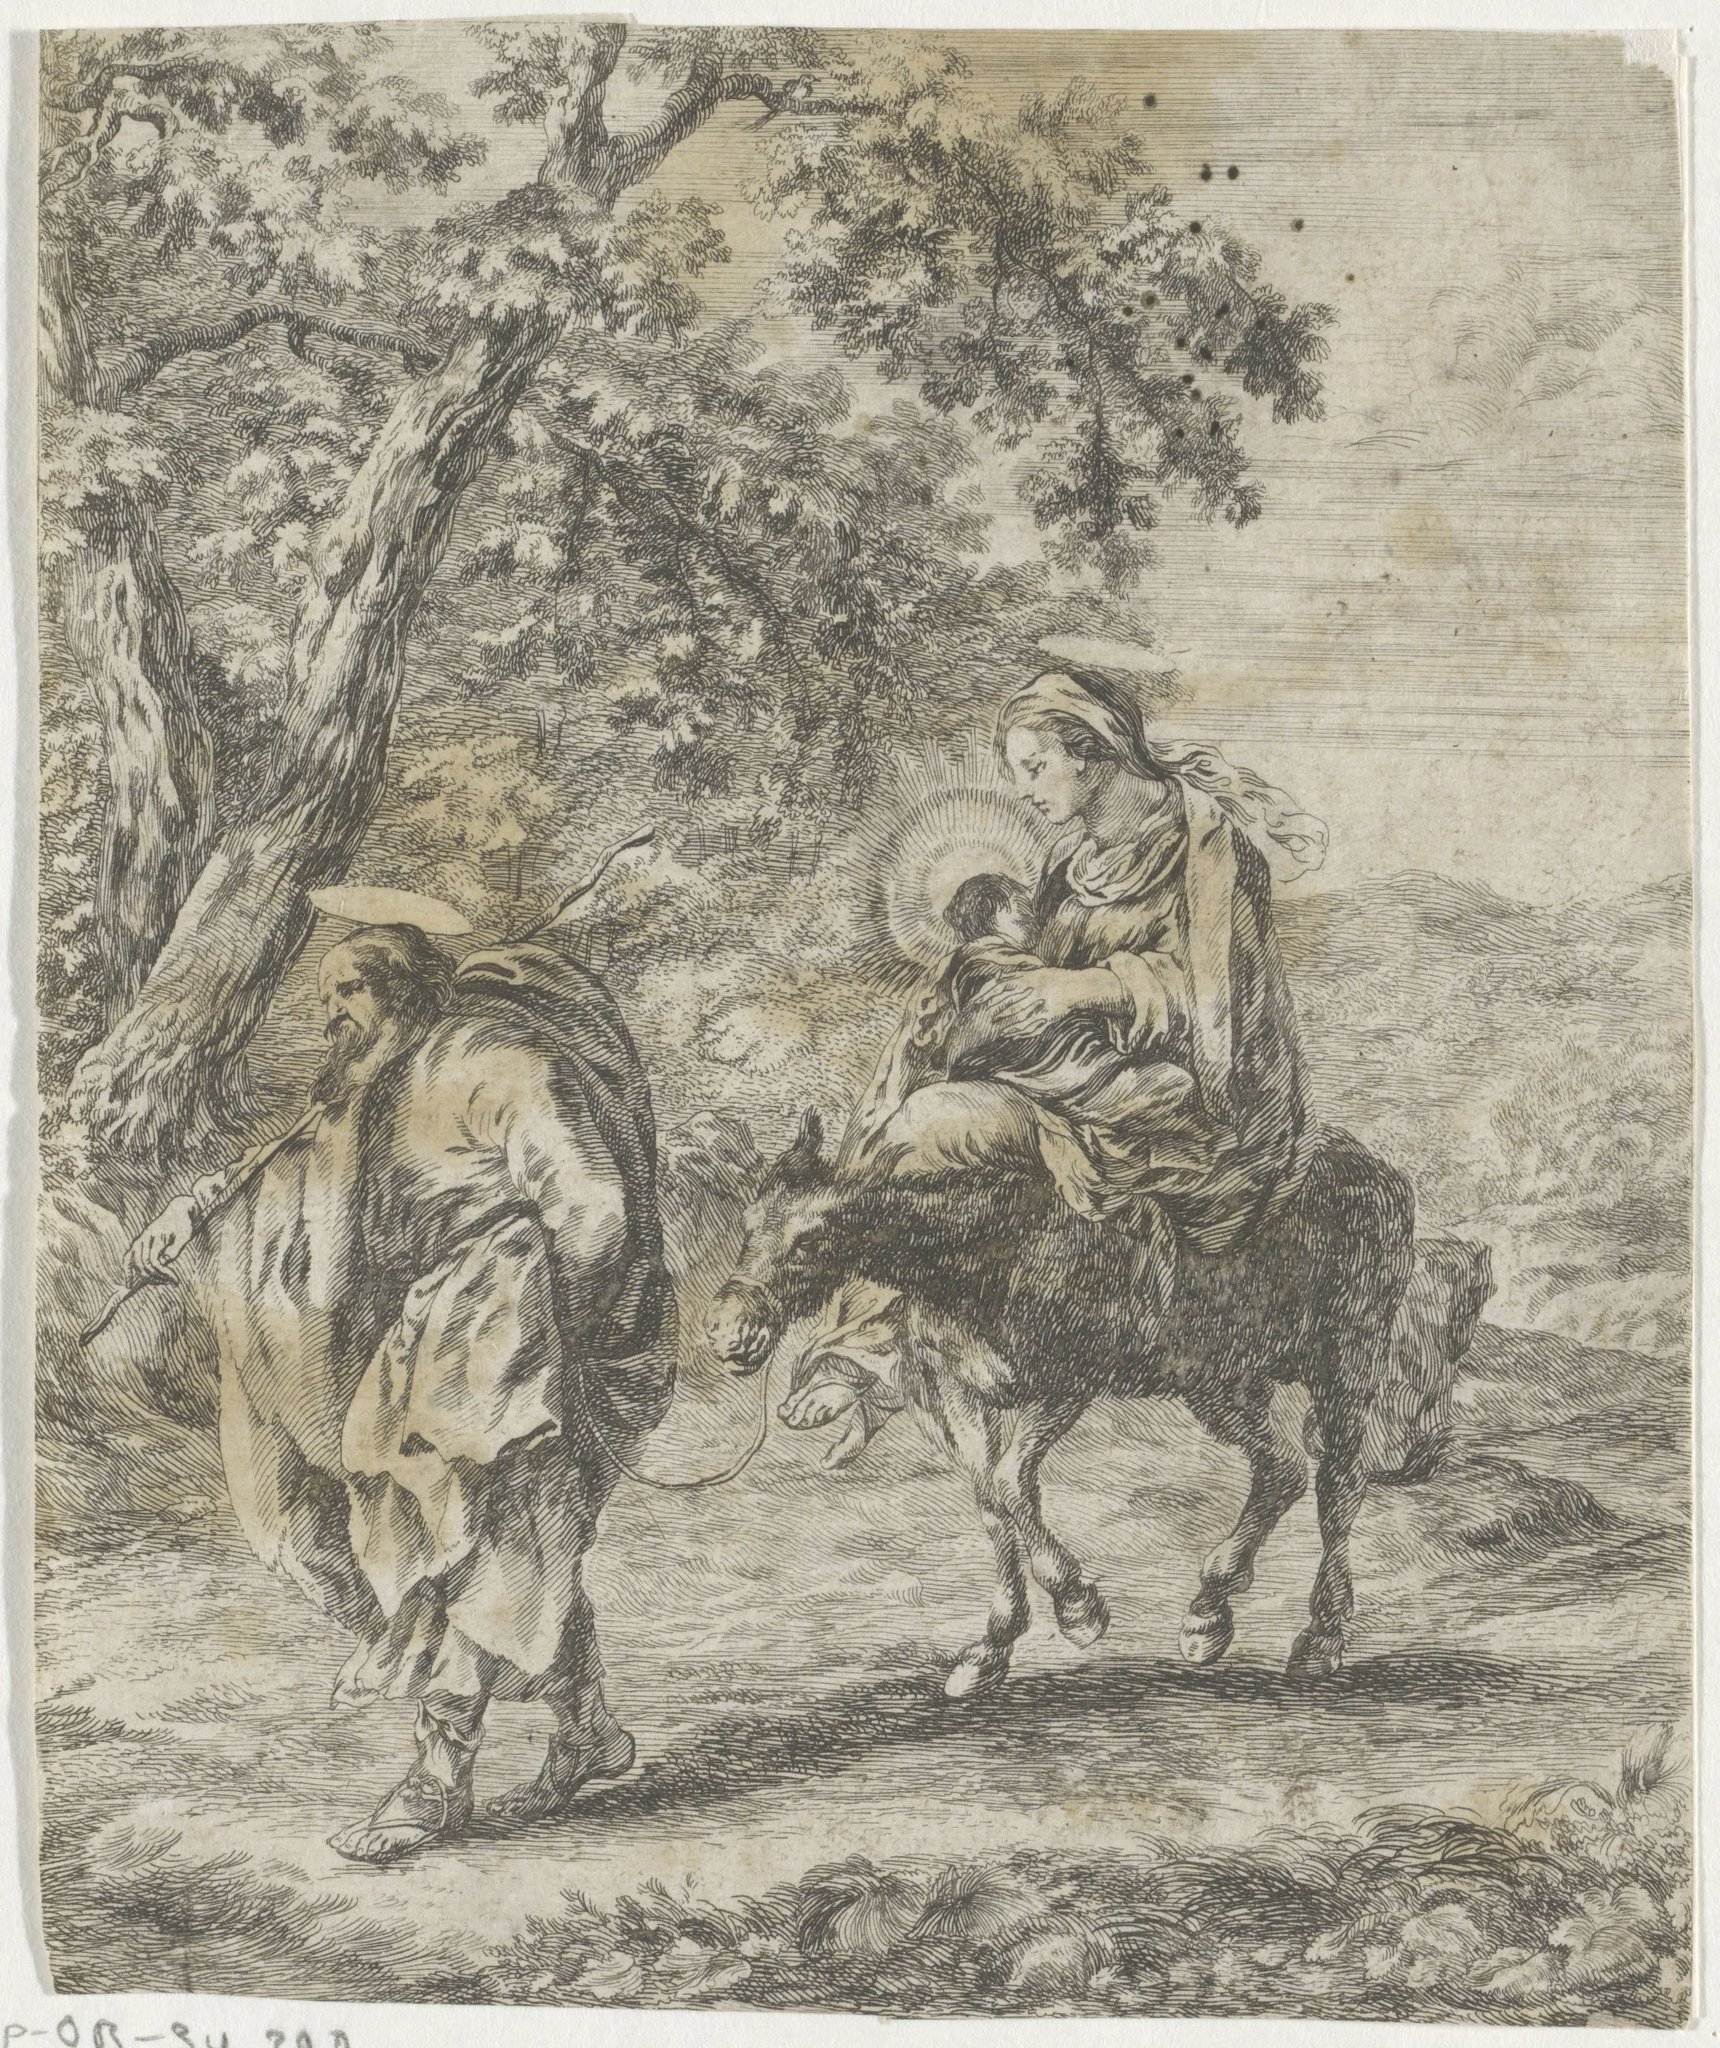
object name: print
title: Vlucht naar Egypte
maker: Anonymous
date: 1620-1664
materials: paper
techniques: etching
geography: italy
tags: the flight into egypt: mary, joseph, the child (and sometimes others) on their way; mary usually riding on an ass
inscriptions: collector's mark: Lugt 2228, collector's mark: Lugt 2028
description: Maria zit samen met het Christuskind op een ezel. Jozef trekt de ezel voort.